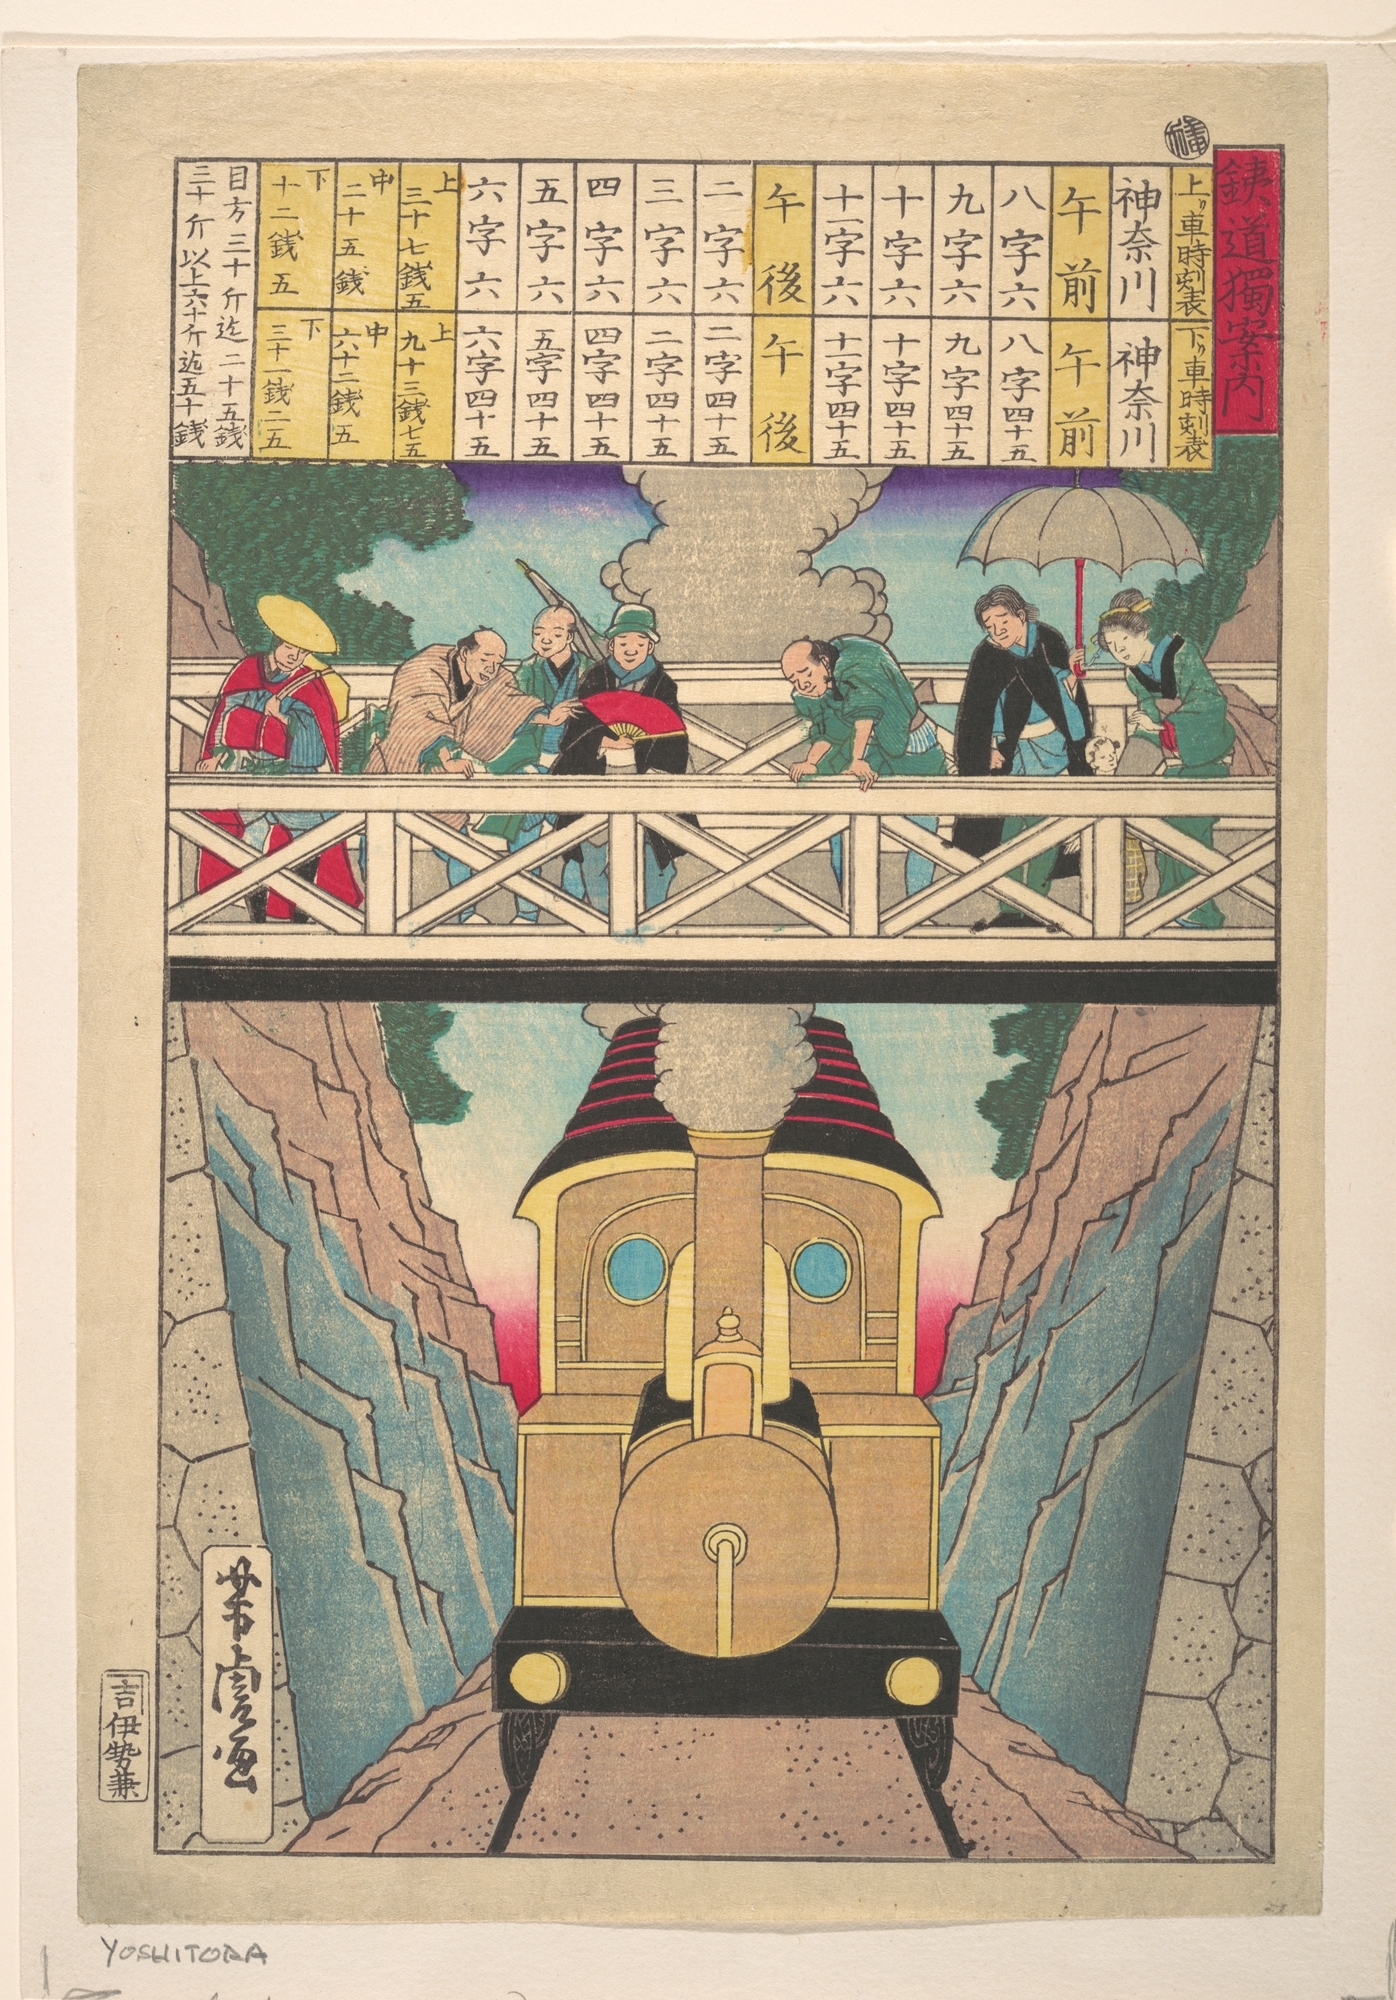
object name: print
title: Solitary Traveler's Guide to Railway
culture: japanese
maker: utagawa yoshitora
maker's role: artist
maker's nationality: japanese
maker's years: 1845-1880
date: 1801-1900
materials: ink, paper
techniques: woodblock print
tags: bridges,men,women,trains